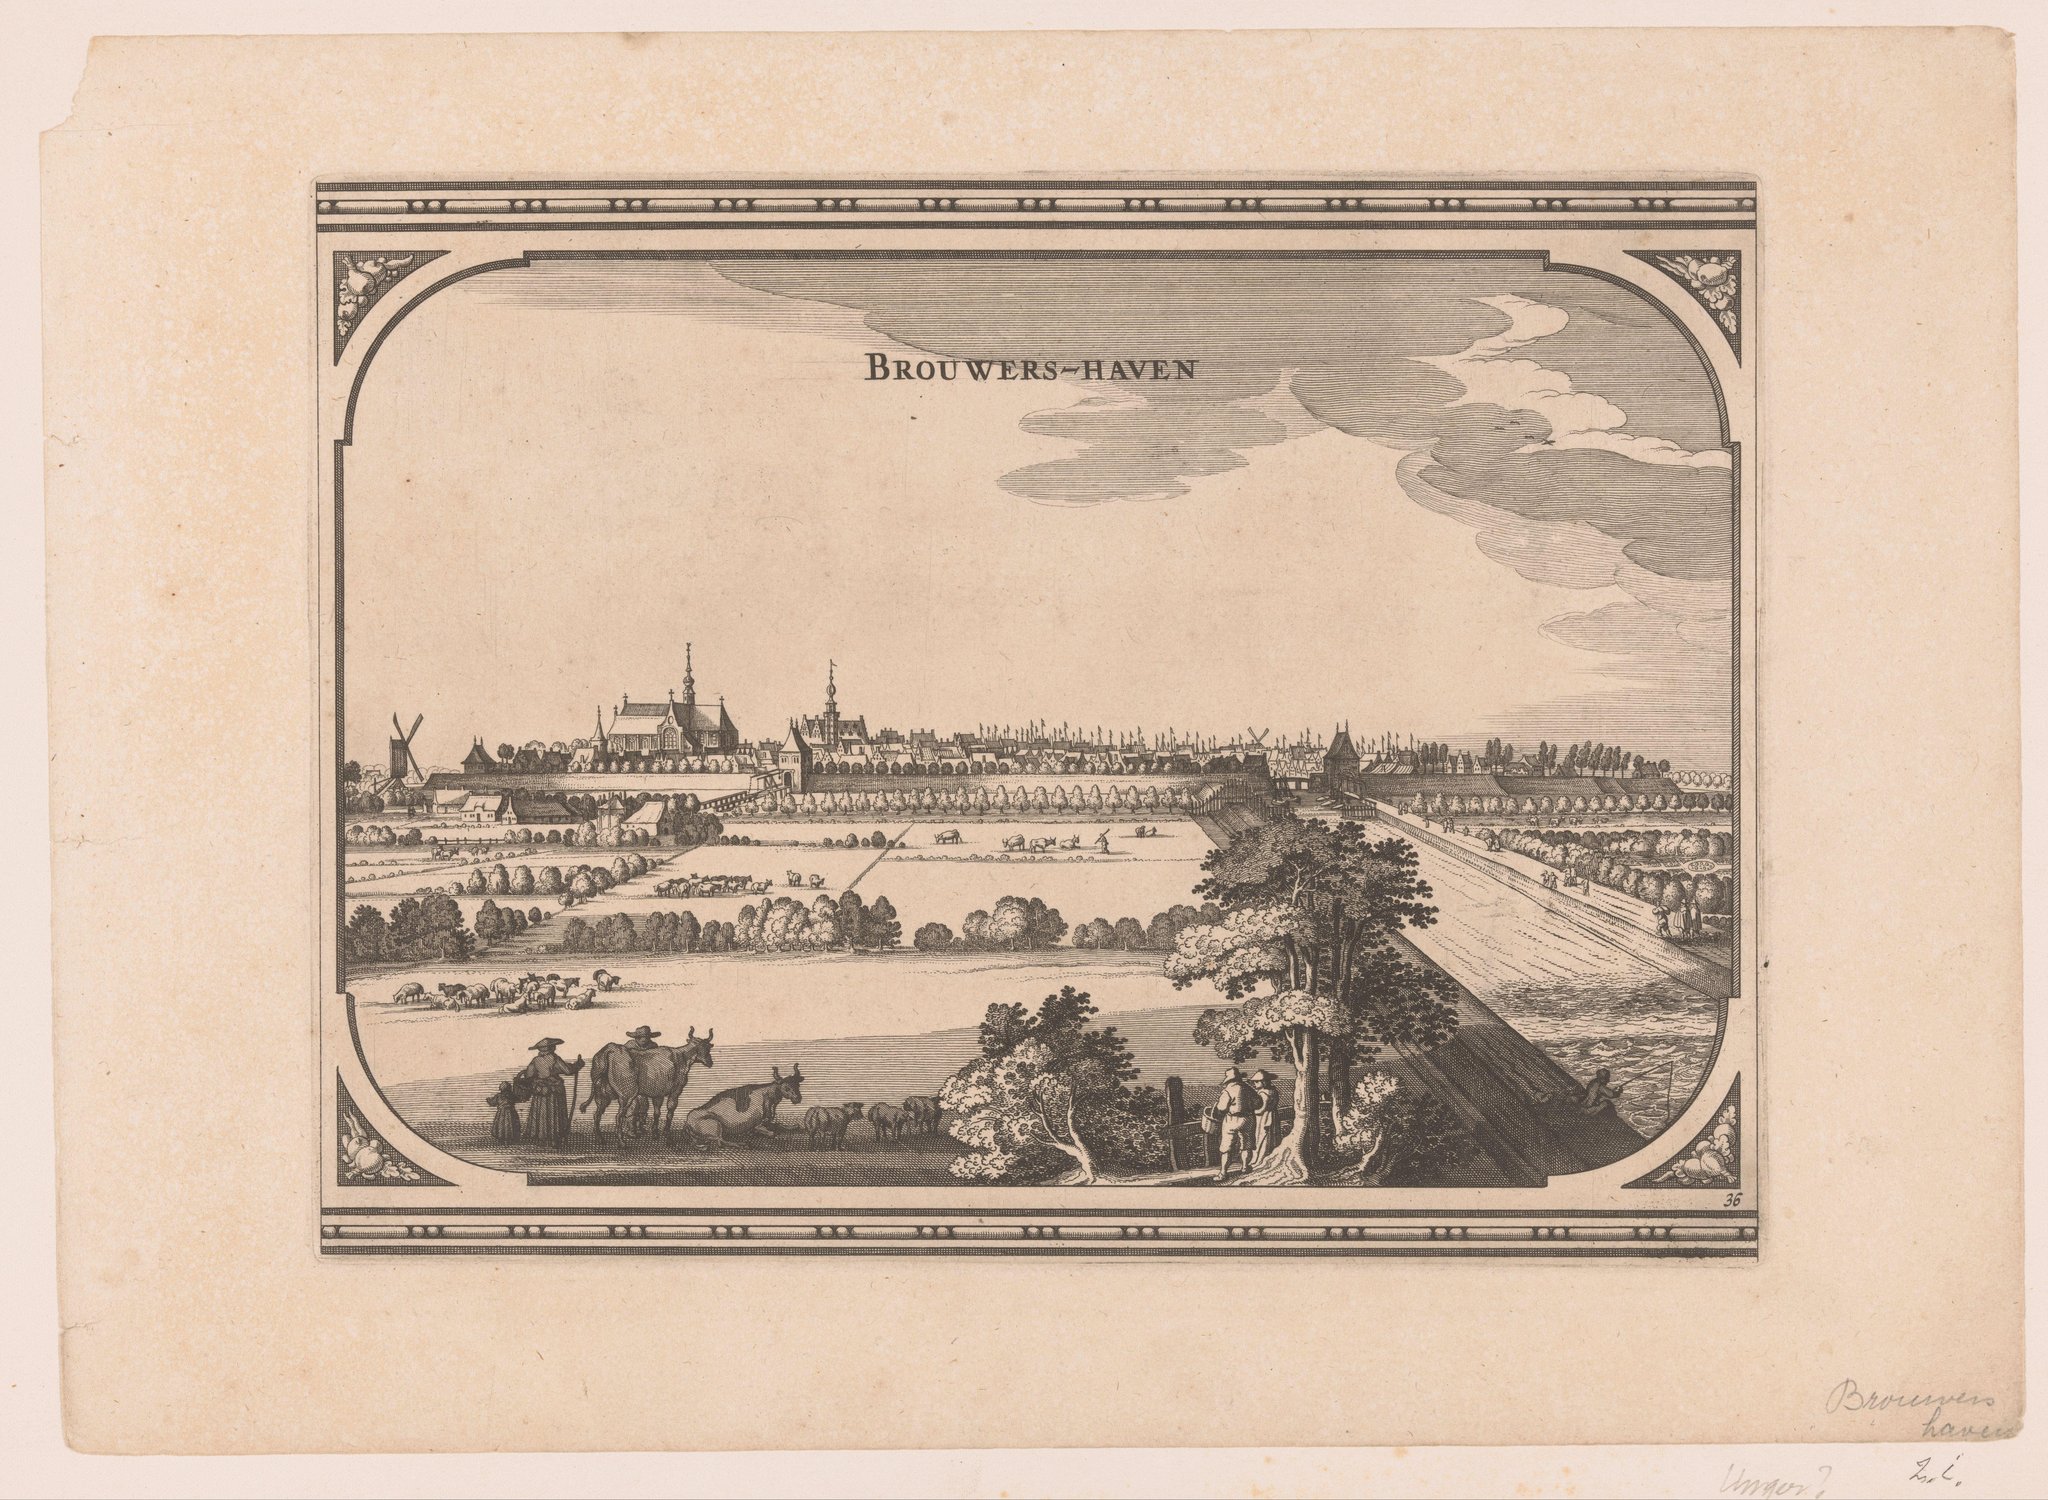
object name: print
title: Brouwers-Haven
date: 1656-1657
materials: paper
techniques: etching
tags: prospect of village, silhouette of village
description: Prent verschenen in: Theatrum praecipuarum urbium ducatus Brababtiae necnon comitatum Flandriae et Zelandiae. Amsterdam: Nicolaes Visscher, 1657. En in: Schut, Pieter Hendricksz.Theatrum praecipuarum urbium ducatus Brababtiae necnon comitatum Flandriae et Zelandiae. Amsterdam: Nicolaes Visscher, 1657. En in: Caerten en Steden van Brabant, Vlaenderen ende Zeelandt, Middelburg. Middelburg: Zacharias Roman, Amsterdam: Nicolaes Visscher, 1656. Verschillende staten van prenten zijn gebruikt in uitgaven van 'Speculum Zelandiae' en in andere publicaties uitgegeven door Zacharias Roman en Nicolaes Visscher (I). Verwarring rondom de datering kan ontstaan door het feit dat de prenten uit 'Speculum Zelandiae' ook voorkomen in eerder uitgegeven publicaties, waar ze later in zijn ingebonden. Zo komen prenten uitgegeven door Roman/Visscher voor in sommige exemplaren van: Boxhorn, Marcus Zuerius van. Chroniick van Zeelandt (…). 2 dln. Middelburg: Zacharias Roman, 1644. De door weduwe (Joachim) Ottens en Zoonen uitgegeven prenten zijn later ingebonden in sommige exemplaren van: Smallegange, Mattheus. Nieuwe Cronyk van Zeeland (…). Middelburg en Amsterdam: Johannes Meertens en Abraham van Someren, 1696.